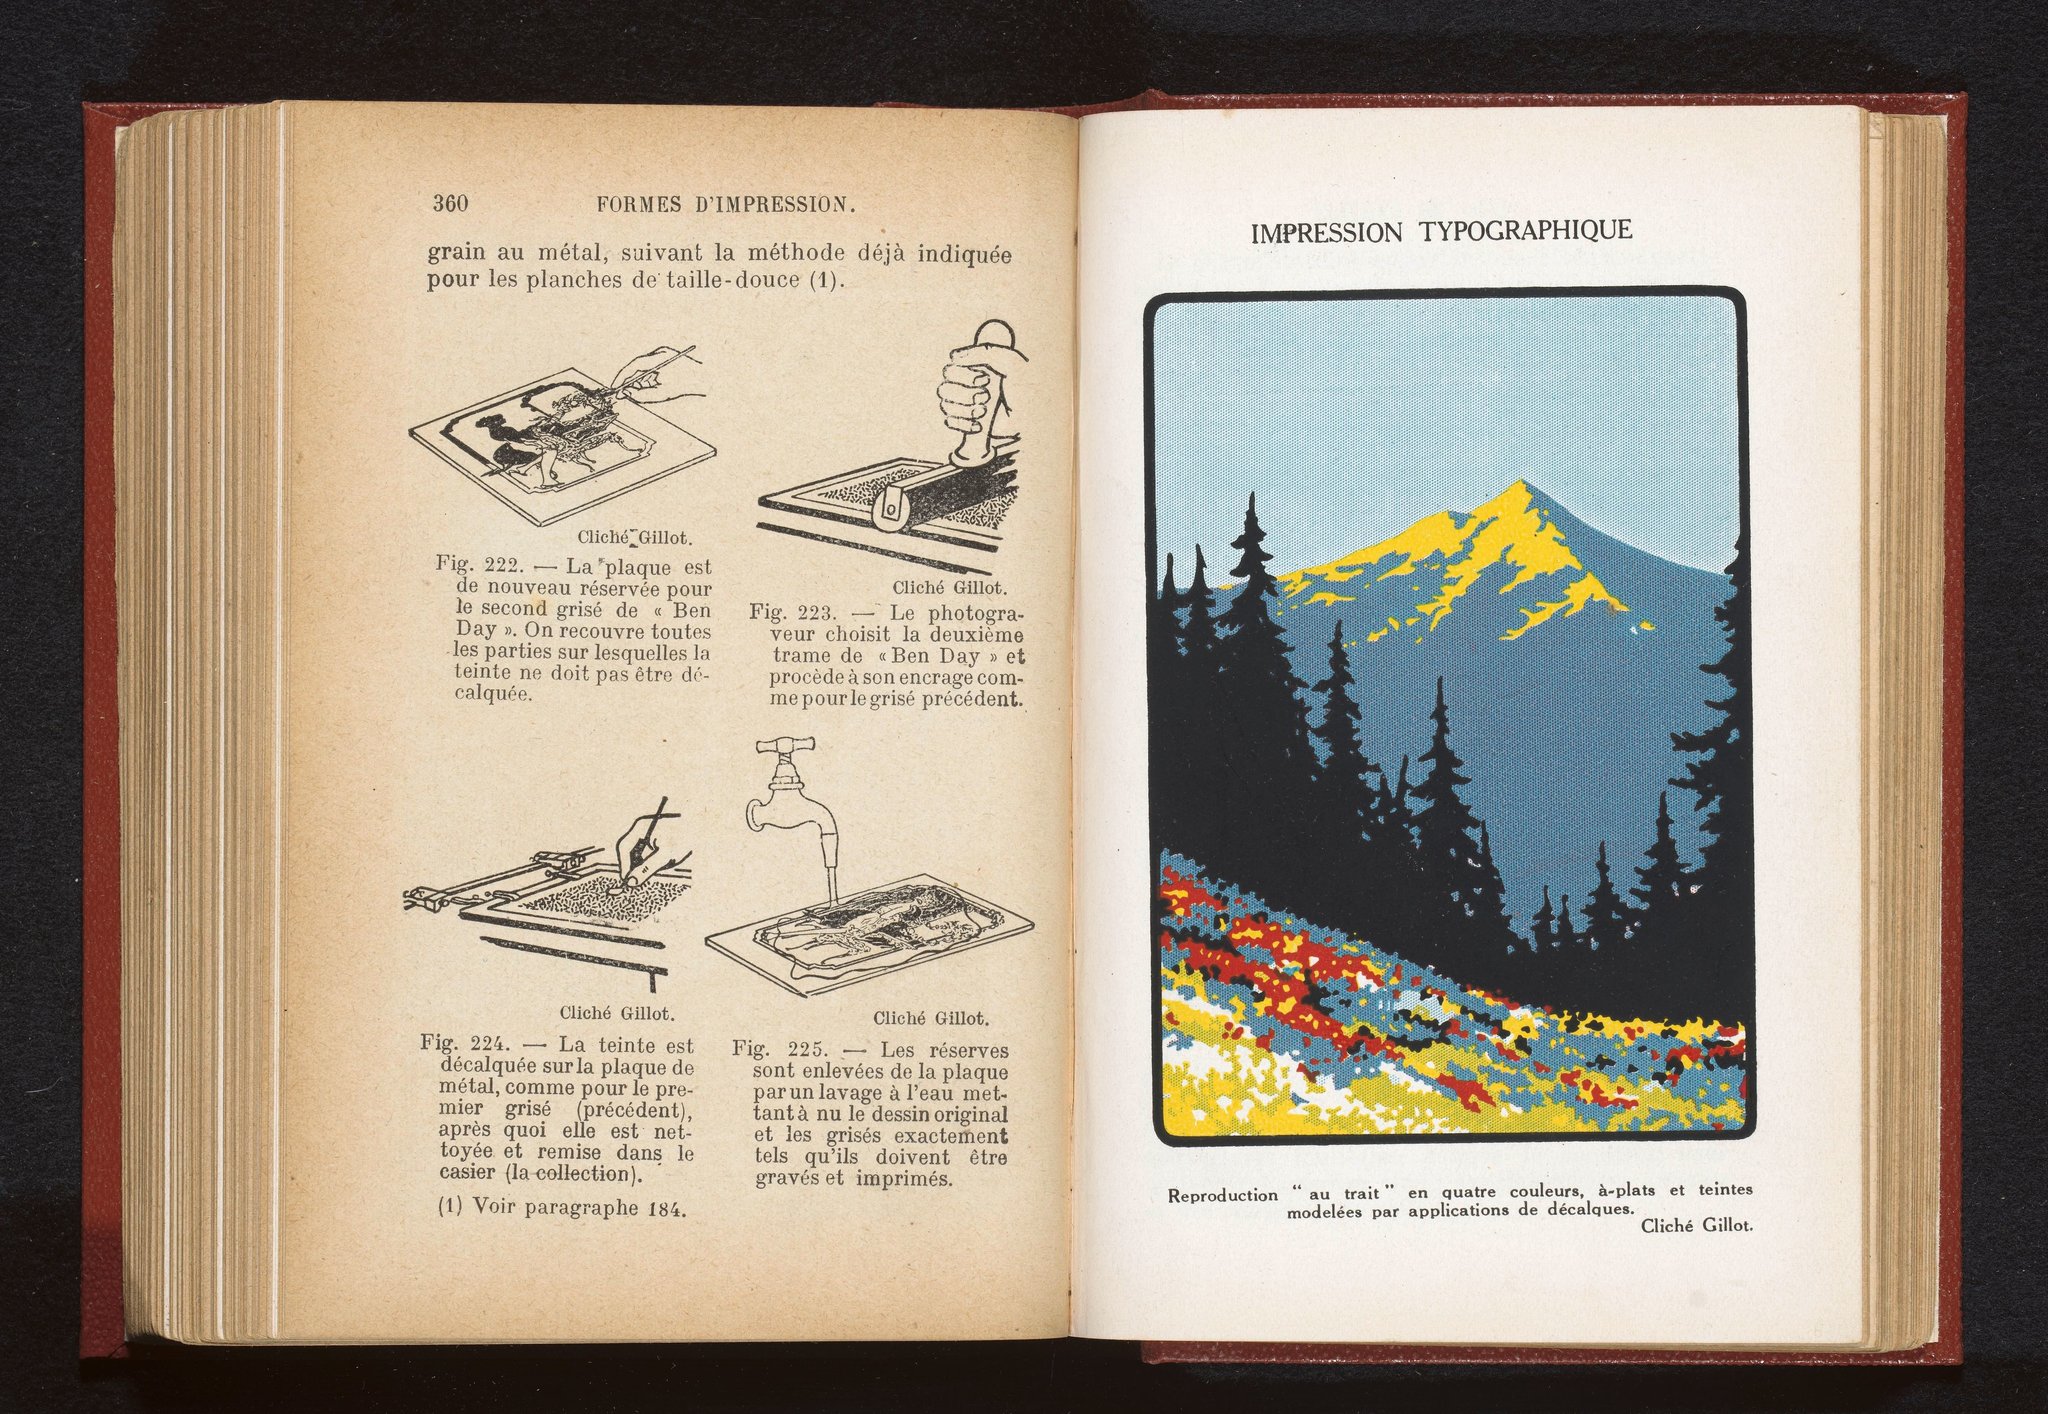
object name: page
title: Fotoreproductie van een prent van een berglandschap in vier kleuren gedrukt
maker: Anonymous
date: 1922-1932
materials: paper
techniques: autotype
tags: print, e.g.: engraving, etching, lithograph, mountains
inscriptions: inscription: ‘reproduction au trait en quatre couleurs, à plats et teintes modelées par applications de décalques’